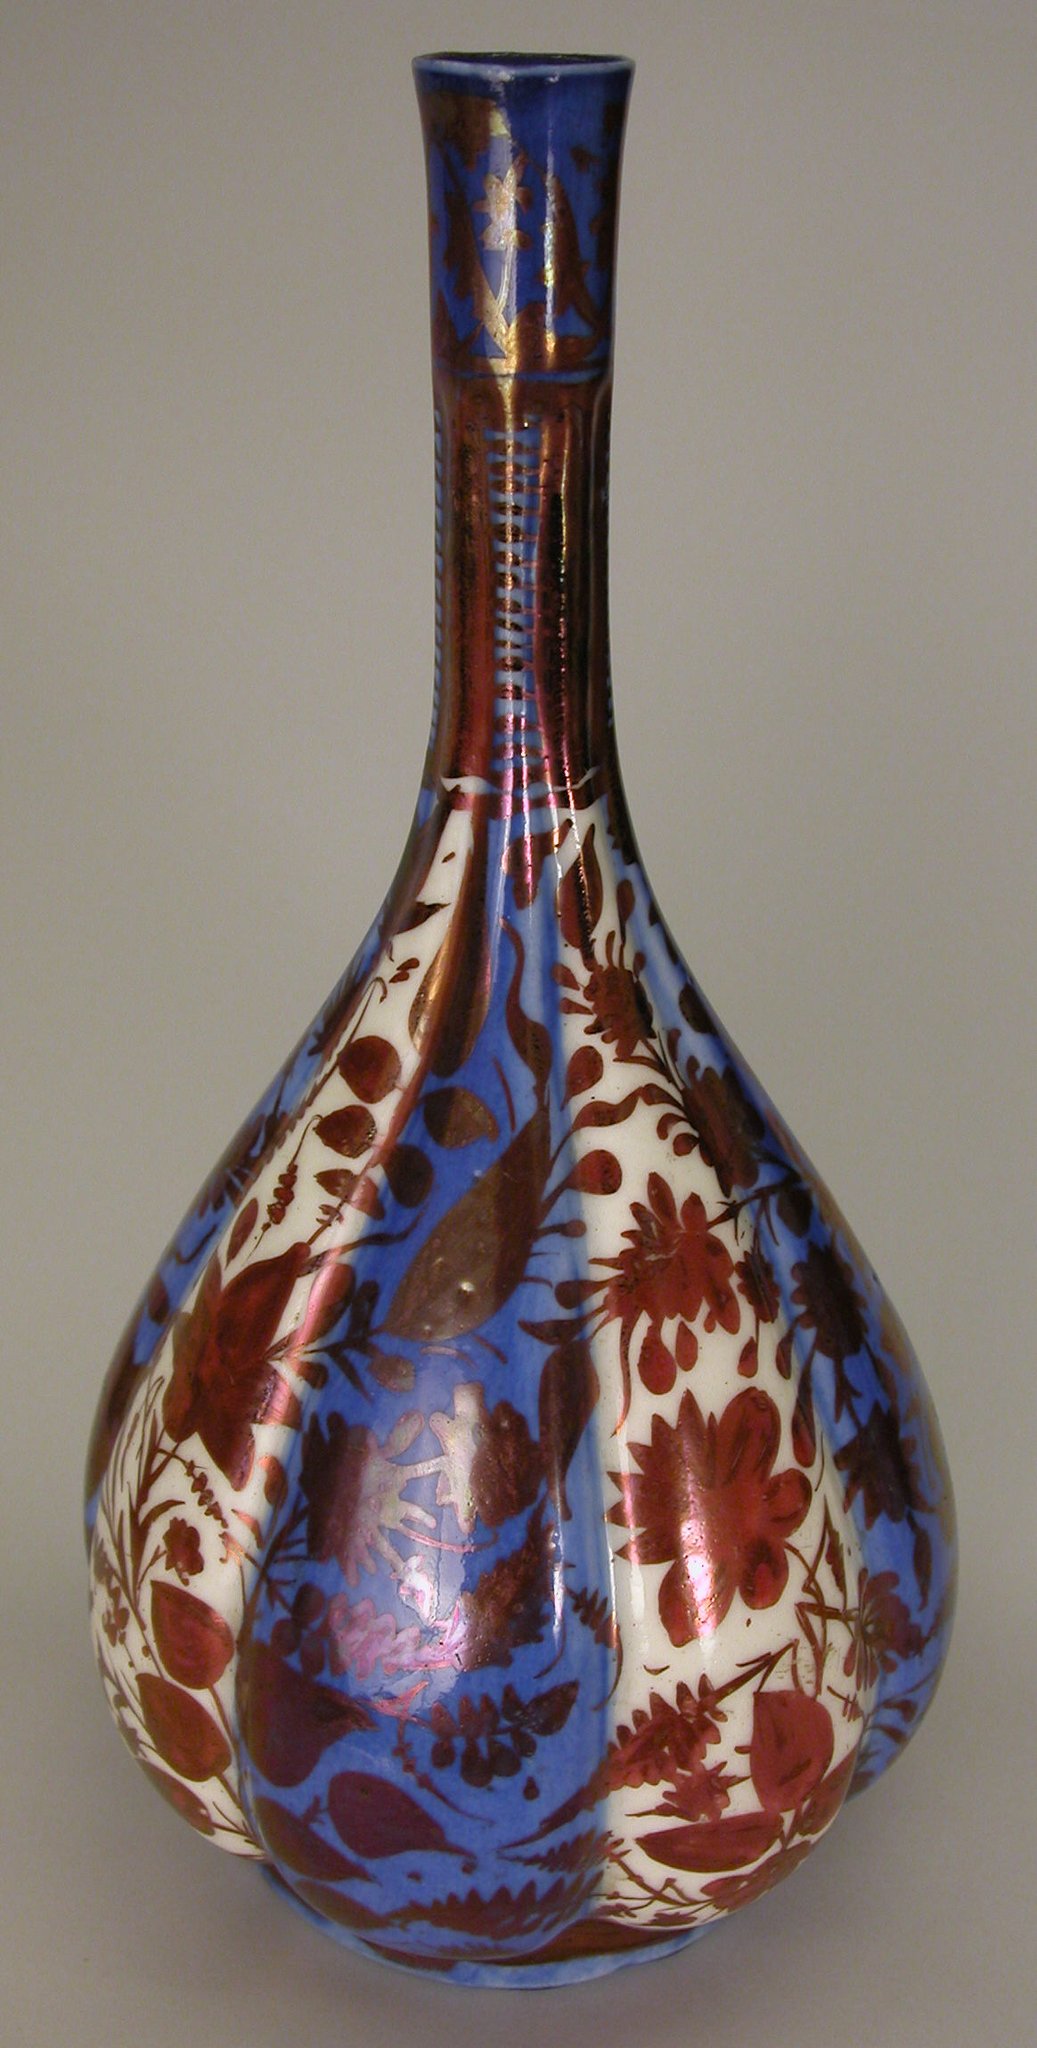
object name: bottle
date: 1651-1700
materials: glaze, stonepaste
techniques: luster painting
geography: iran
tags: flowers